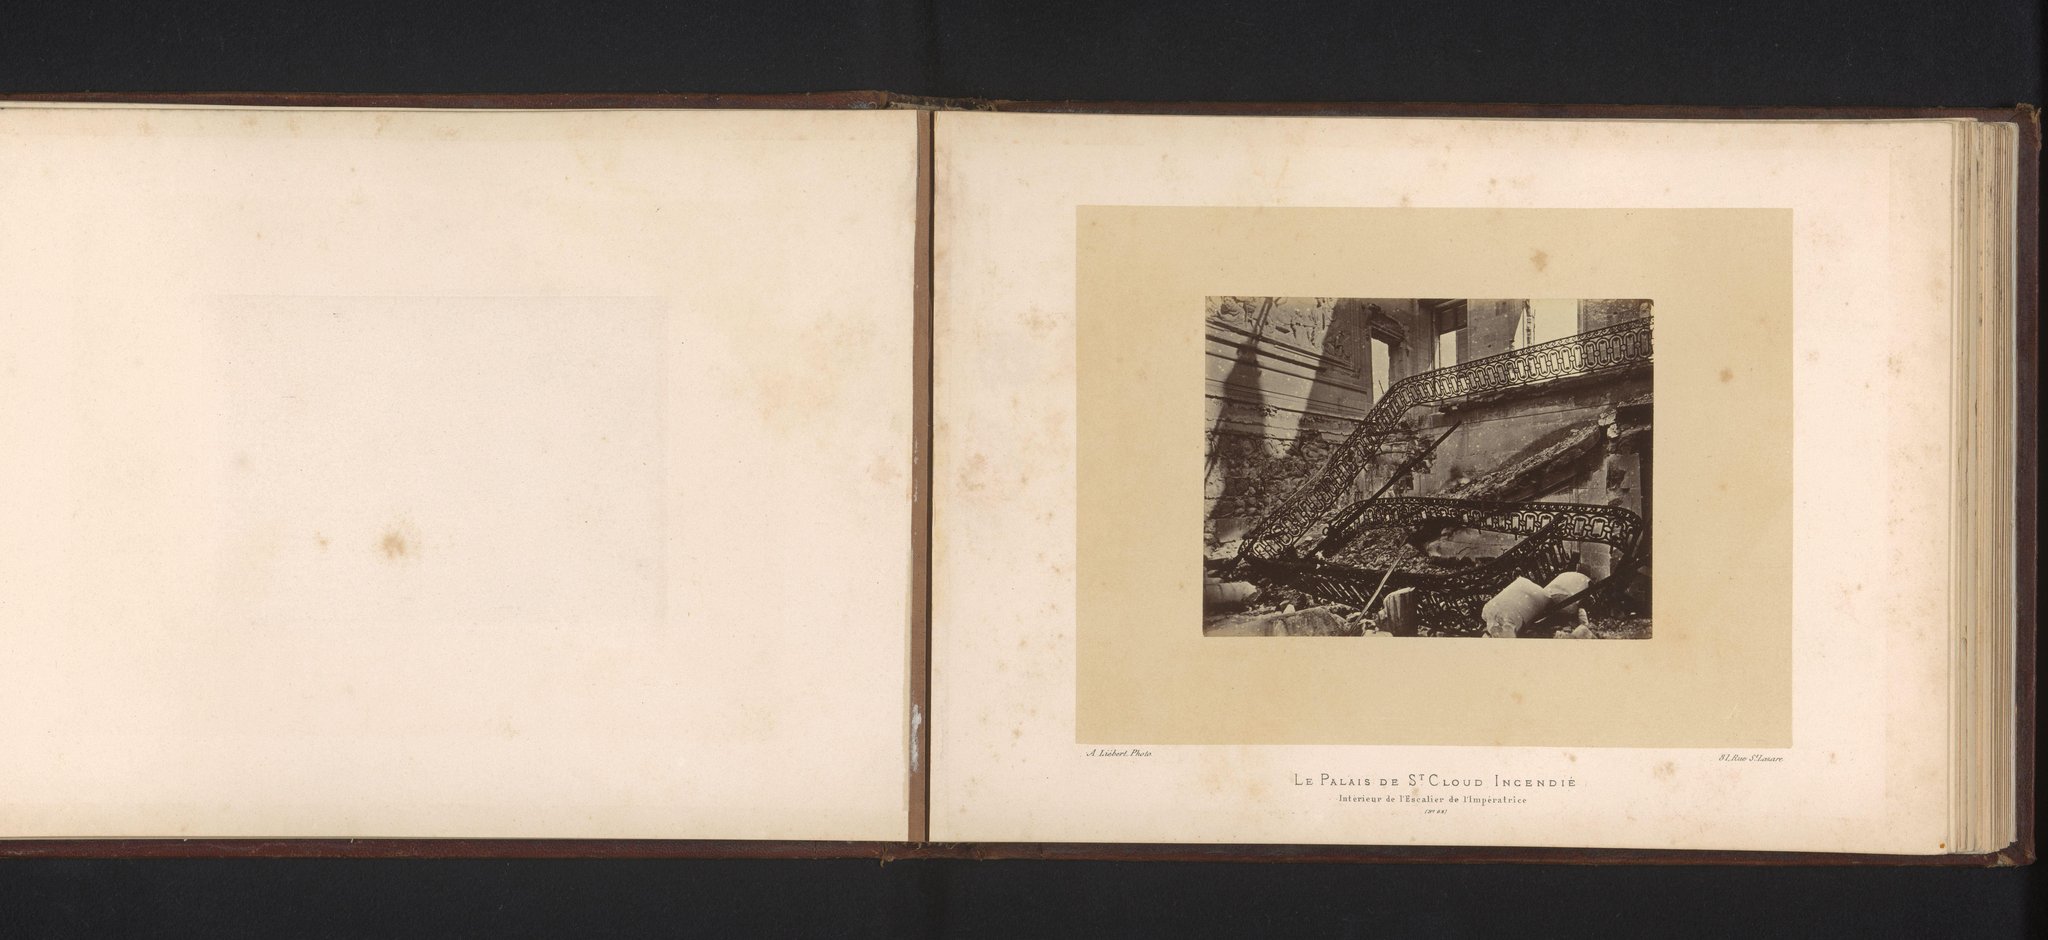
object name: page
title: Le Palais de St. Cloud Incendié. Intérieur de l'Escalier de l'Impératrice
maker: alphonse-justin liébert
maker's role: fotograaf, marinier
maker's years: 1827-1914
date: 1871-1872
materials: photographic support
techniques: albumen print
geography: saint-cloud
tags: stairwell, castle, ruin of a building ~ architecture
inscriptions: number: ‘(No. 62)’, address: ‘31, Rue St. Lazare’